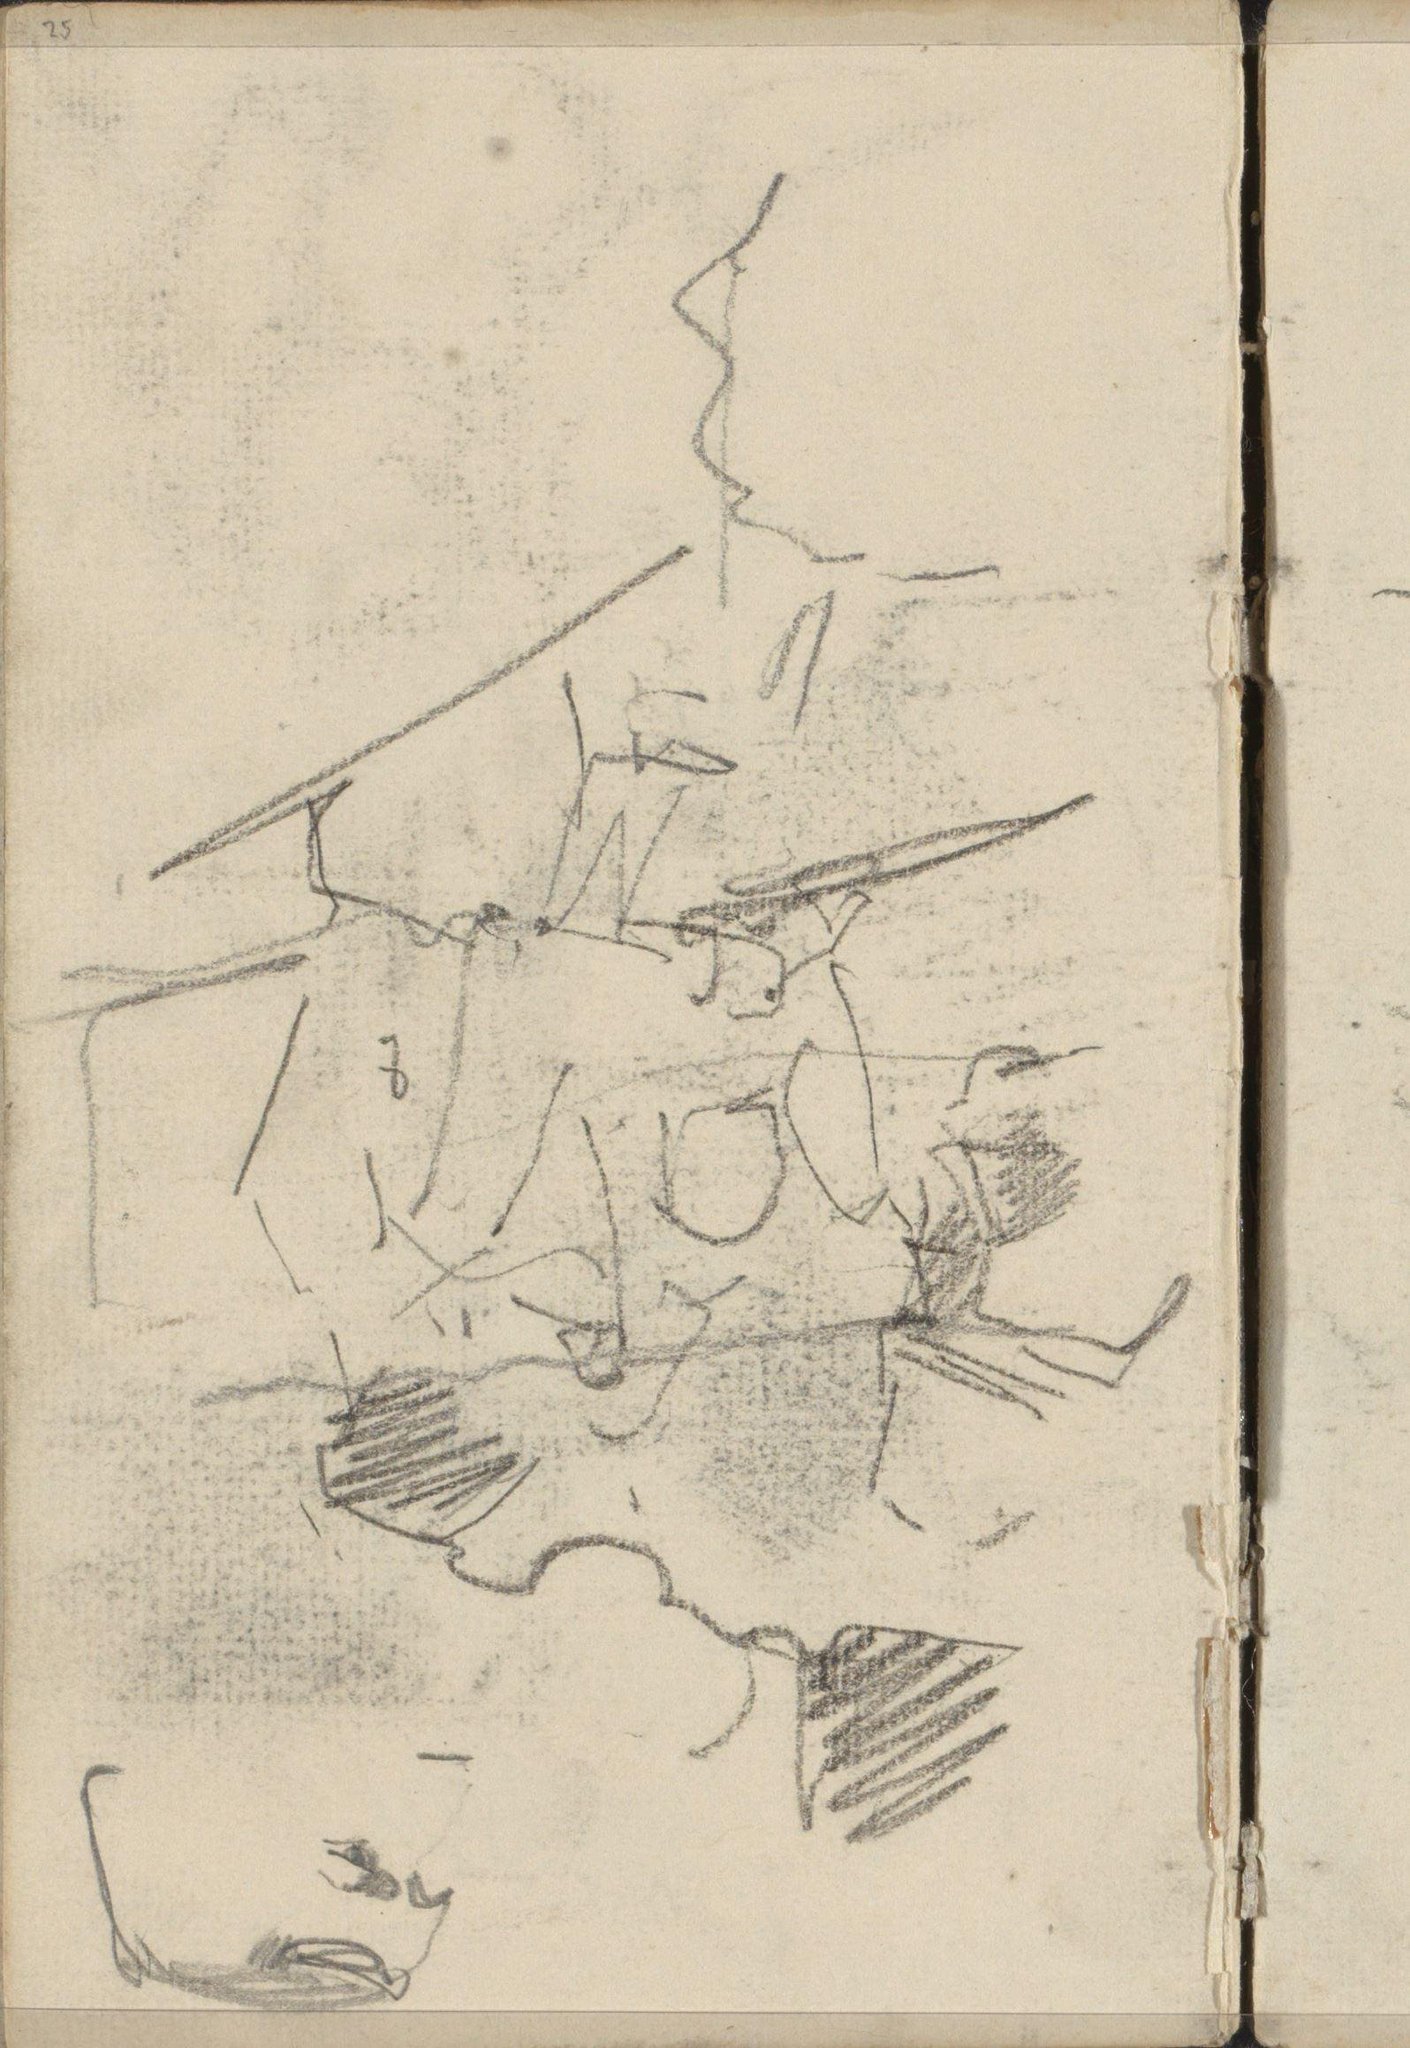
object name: sketchbook leaf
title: Figuurstudies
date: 1882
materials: paper, pencil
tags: head (human) (+ left side visible; left - (l. hand, l. foot, etc.))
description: Pagina 25 uit een schetsboek met 31 bladen vervaardigd te Den Haag en Rotterdam.